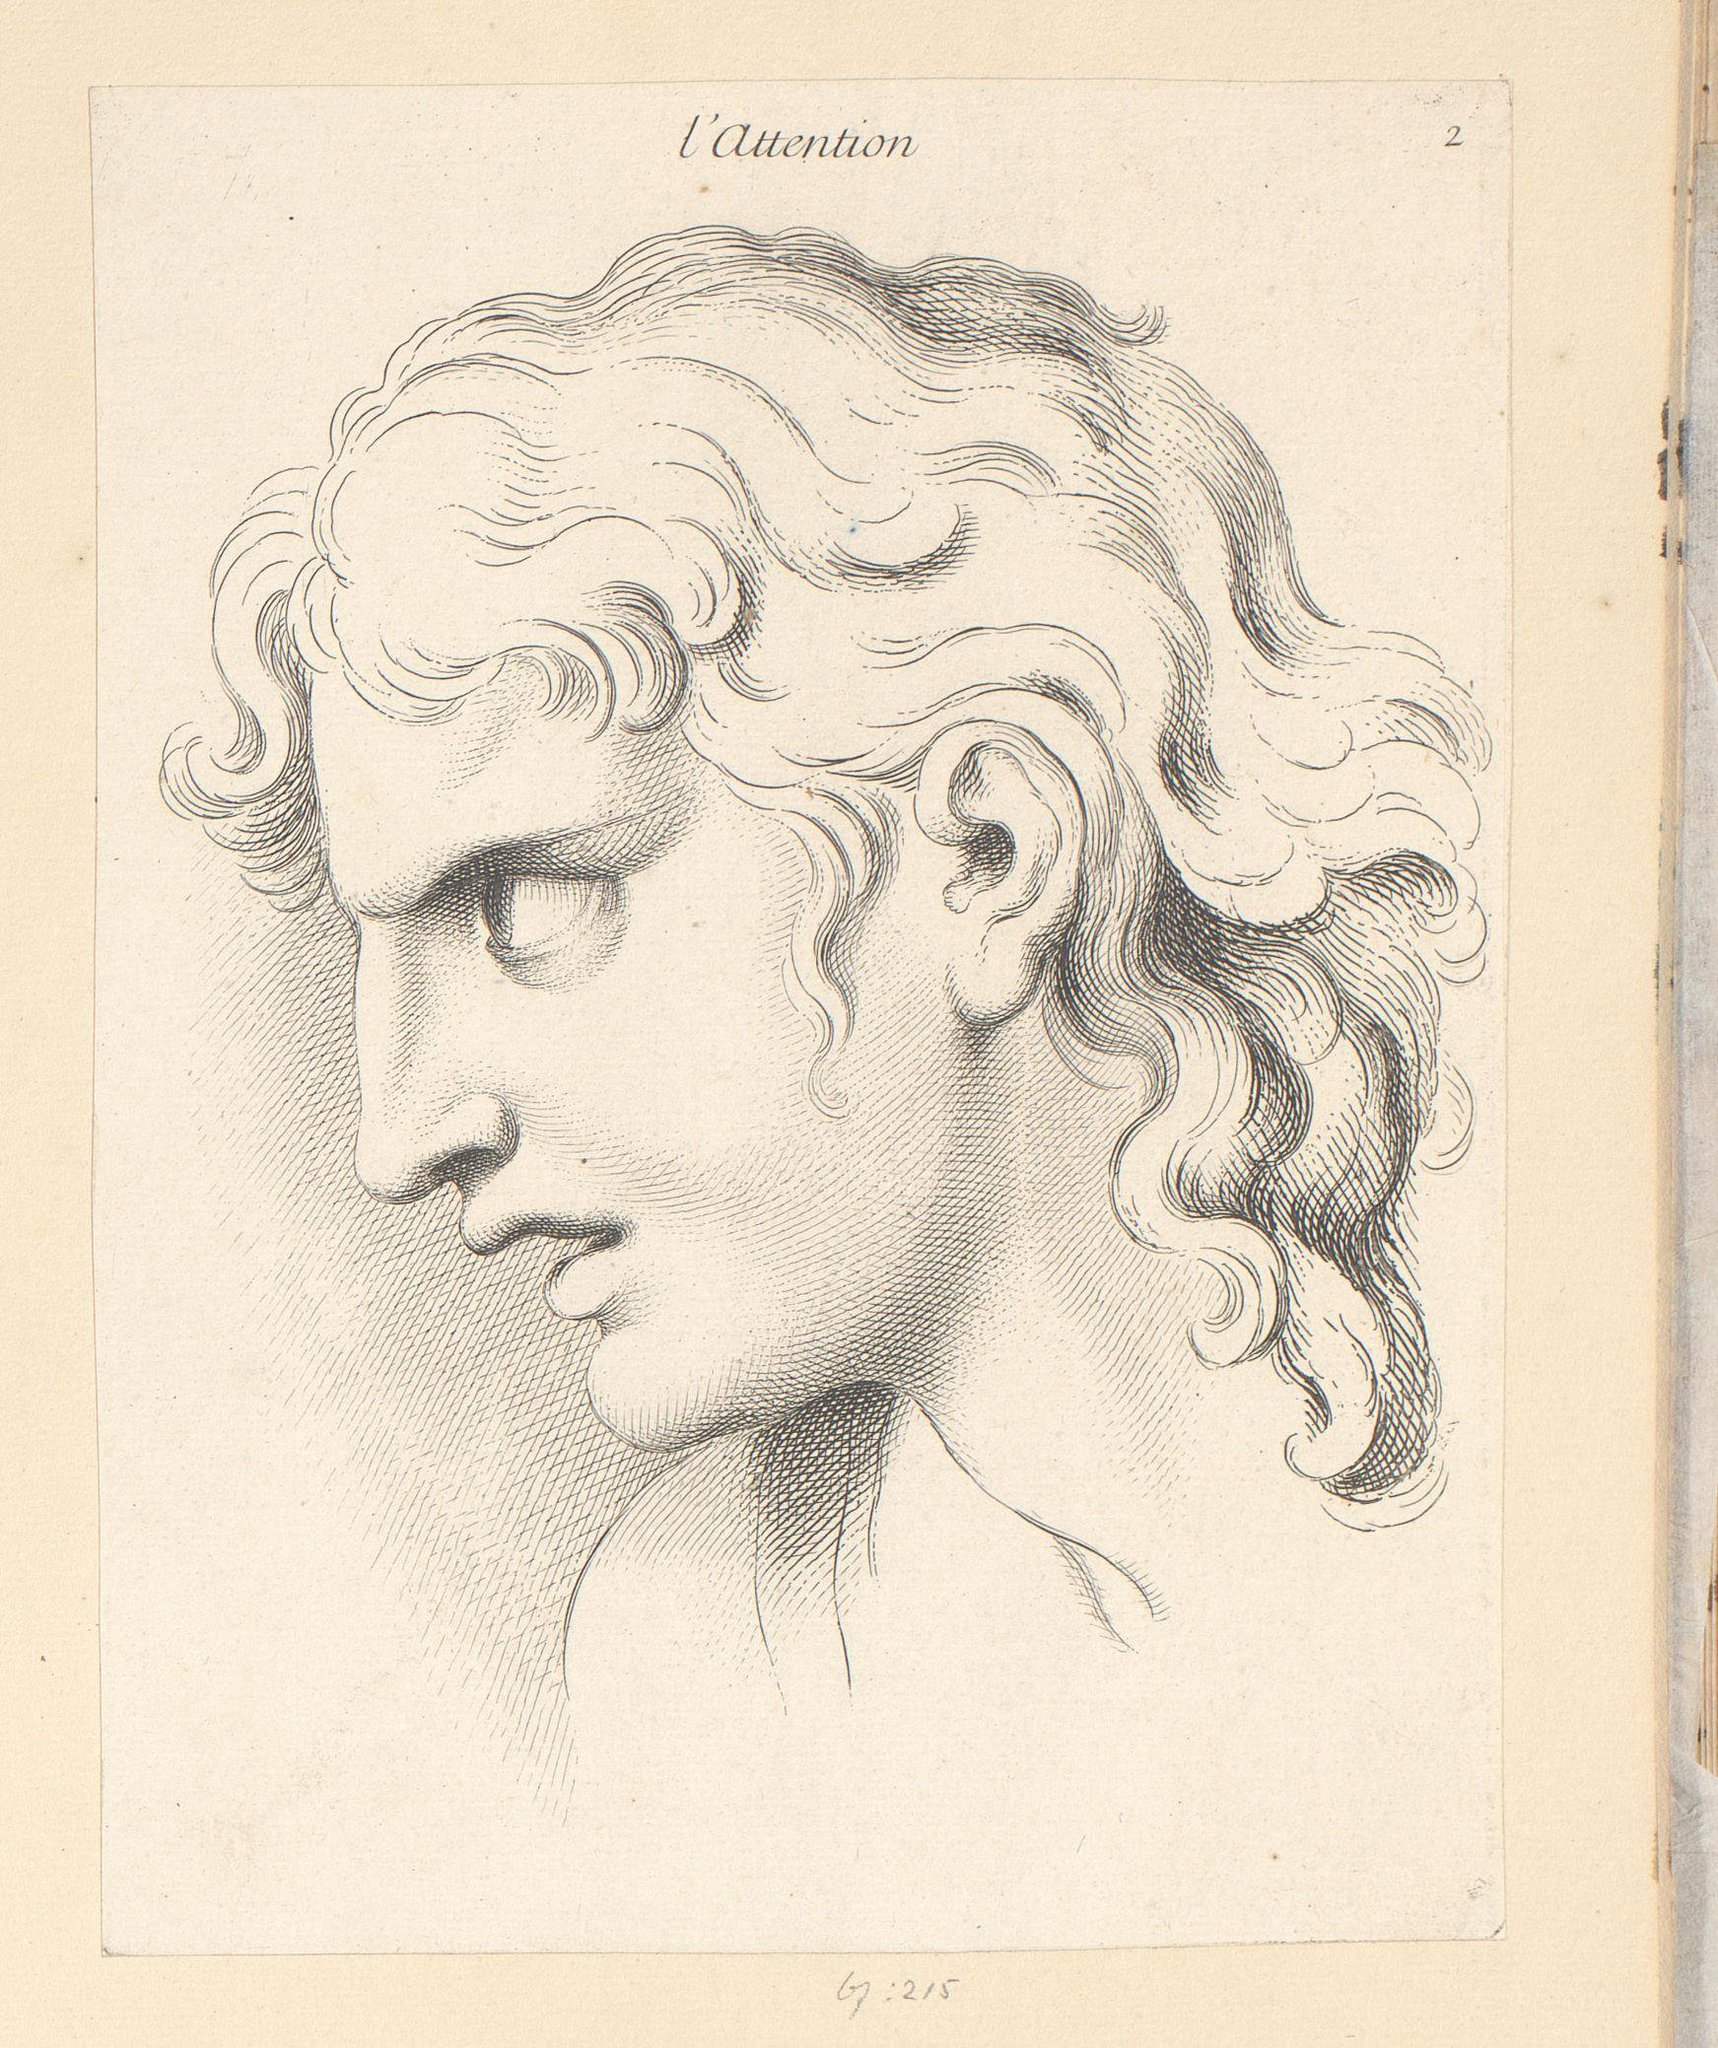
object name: album leaf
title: L'ouvrage de Charles le Brun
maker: jean audran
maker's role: print maker, publisher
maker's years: 1667-1756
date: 1727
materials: paper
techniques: engraving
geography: paris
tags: face, attention, concentration, morphology of facial expression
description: Prent uit: Le Brun, Charles. Expressions des Passions de l'Ame. Representées en plusieurs testes gravées d'apres les desseins de feu Monsieur le Brun, Premier Peintre du Roy. Parijs: Jean Audran, 1727. Reeks van 19 portretten, een titelprent en twee (dubbelzijdig bedrukte) bladen tekst.